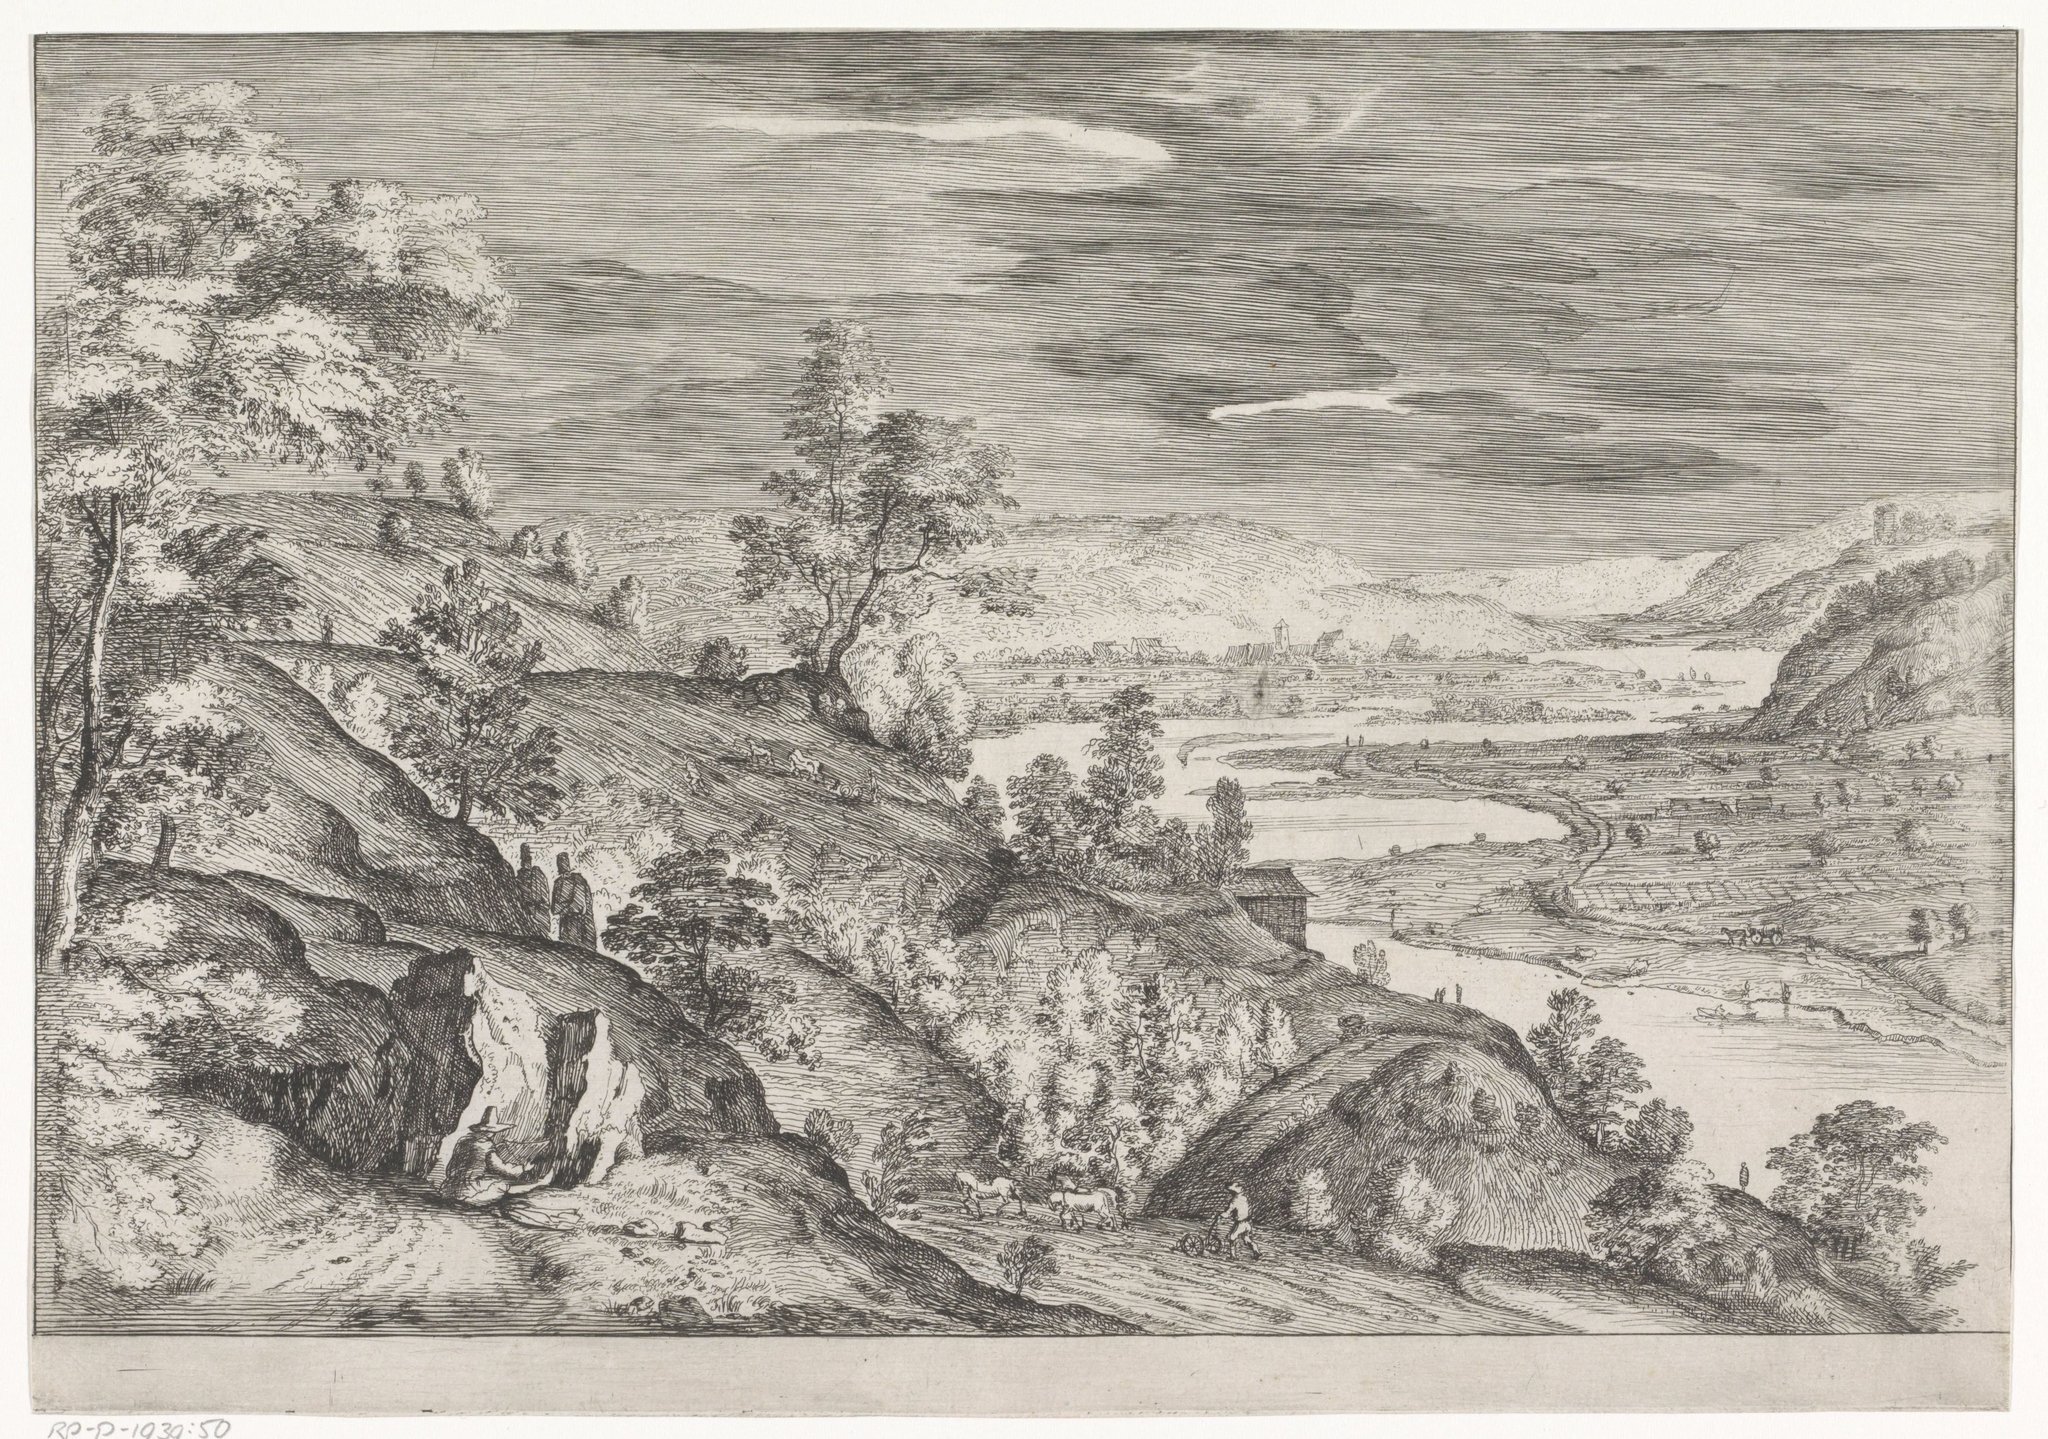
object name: print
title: Heuvelachtig landschap met een rivier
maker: Anonymous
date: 1600-1700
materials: paper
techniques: engraving, etching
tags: river, (high) hill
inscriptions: collector's mark: Lugt 2760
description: Een heuvelachtig landschap met een rivier in het dal. Links op de voorgrond een zittende man met een kaart of papier in zijn handen.